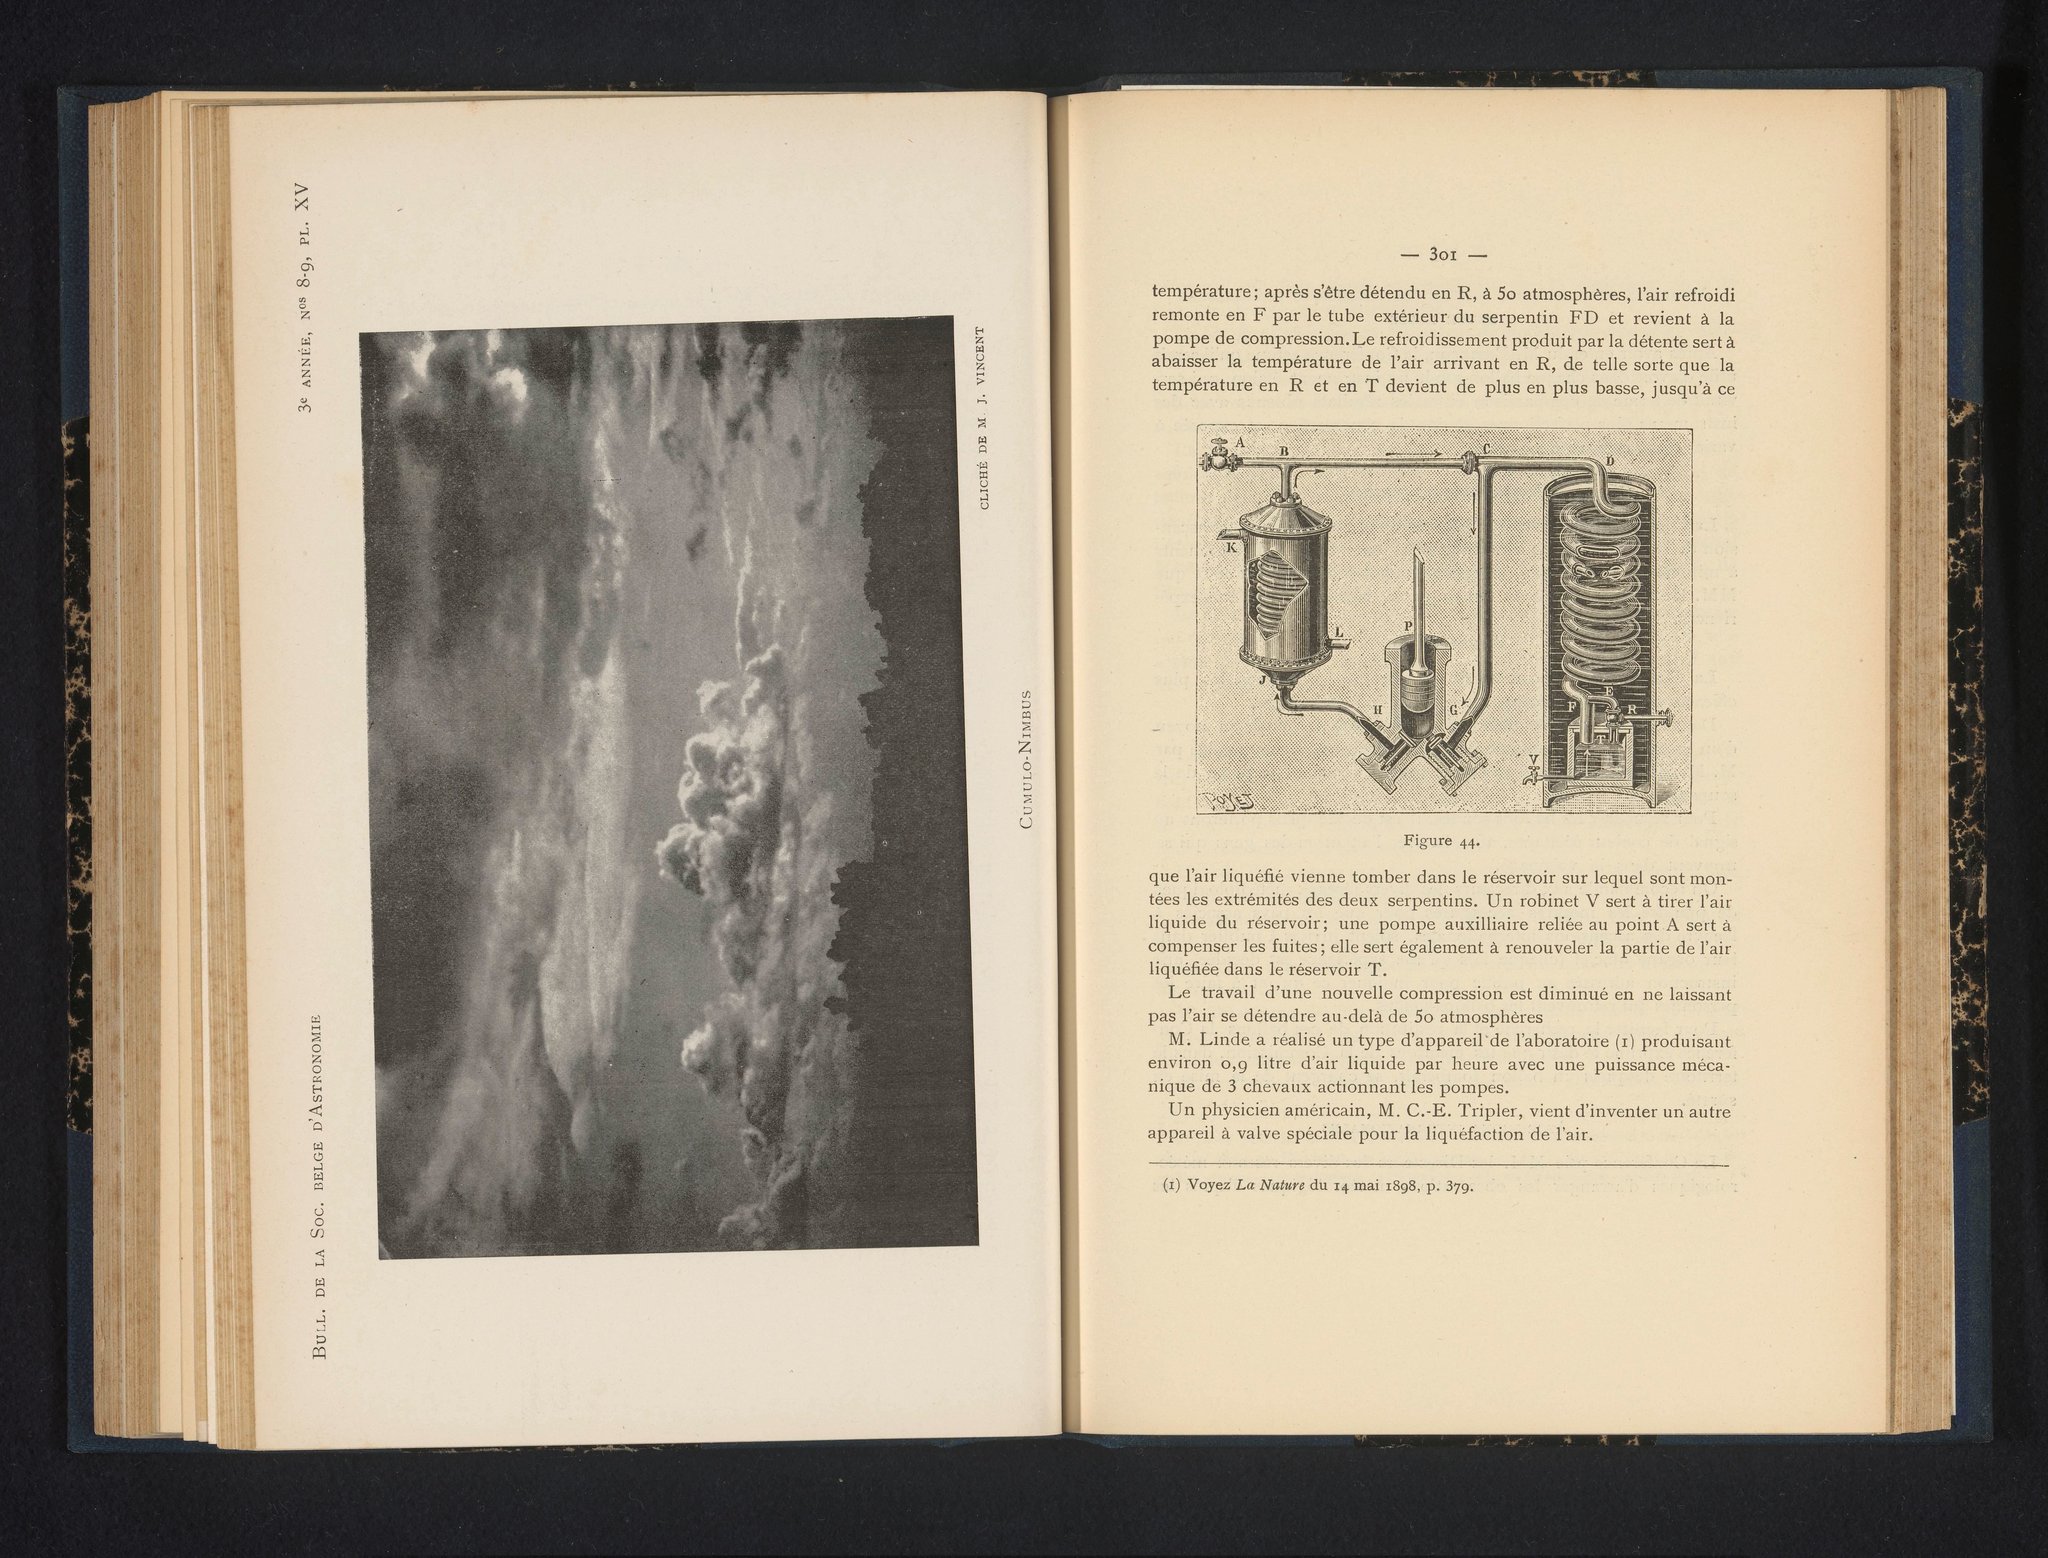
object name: page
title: Cumulo - Nimbus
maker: jean vincent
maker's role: meteoroloog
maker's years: 1851-1932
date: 1893-1898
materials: paper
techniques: autotype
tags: cumulonimbus, i.e. thunder clouds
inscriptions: inscription: ‘3e Année, no 8-9, PL XV.’